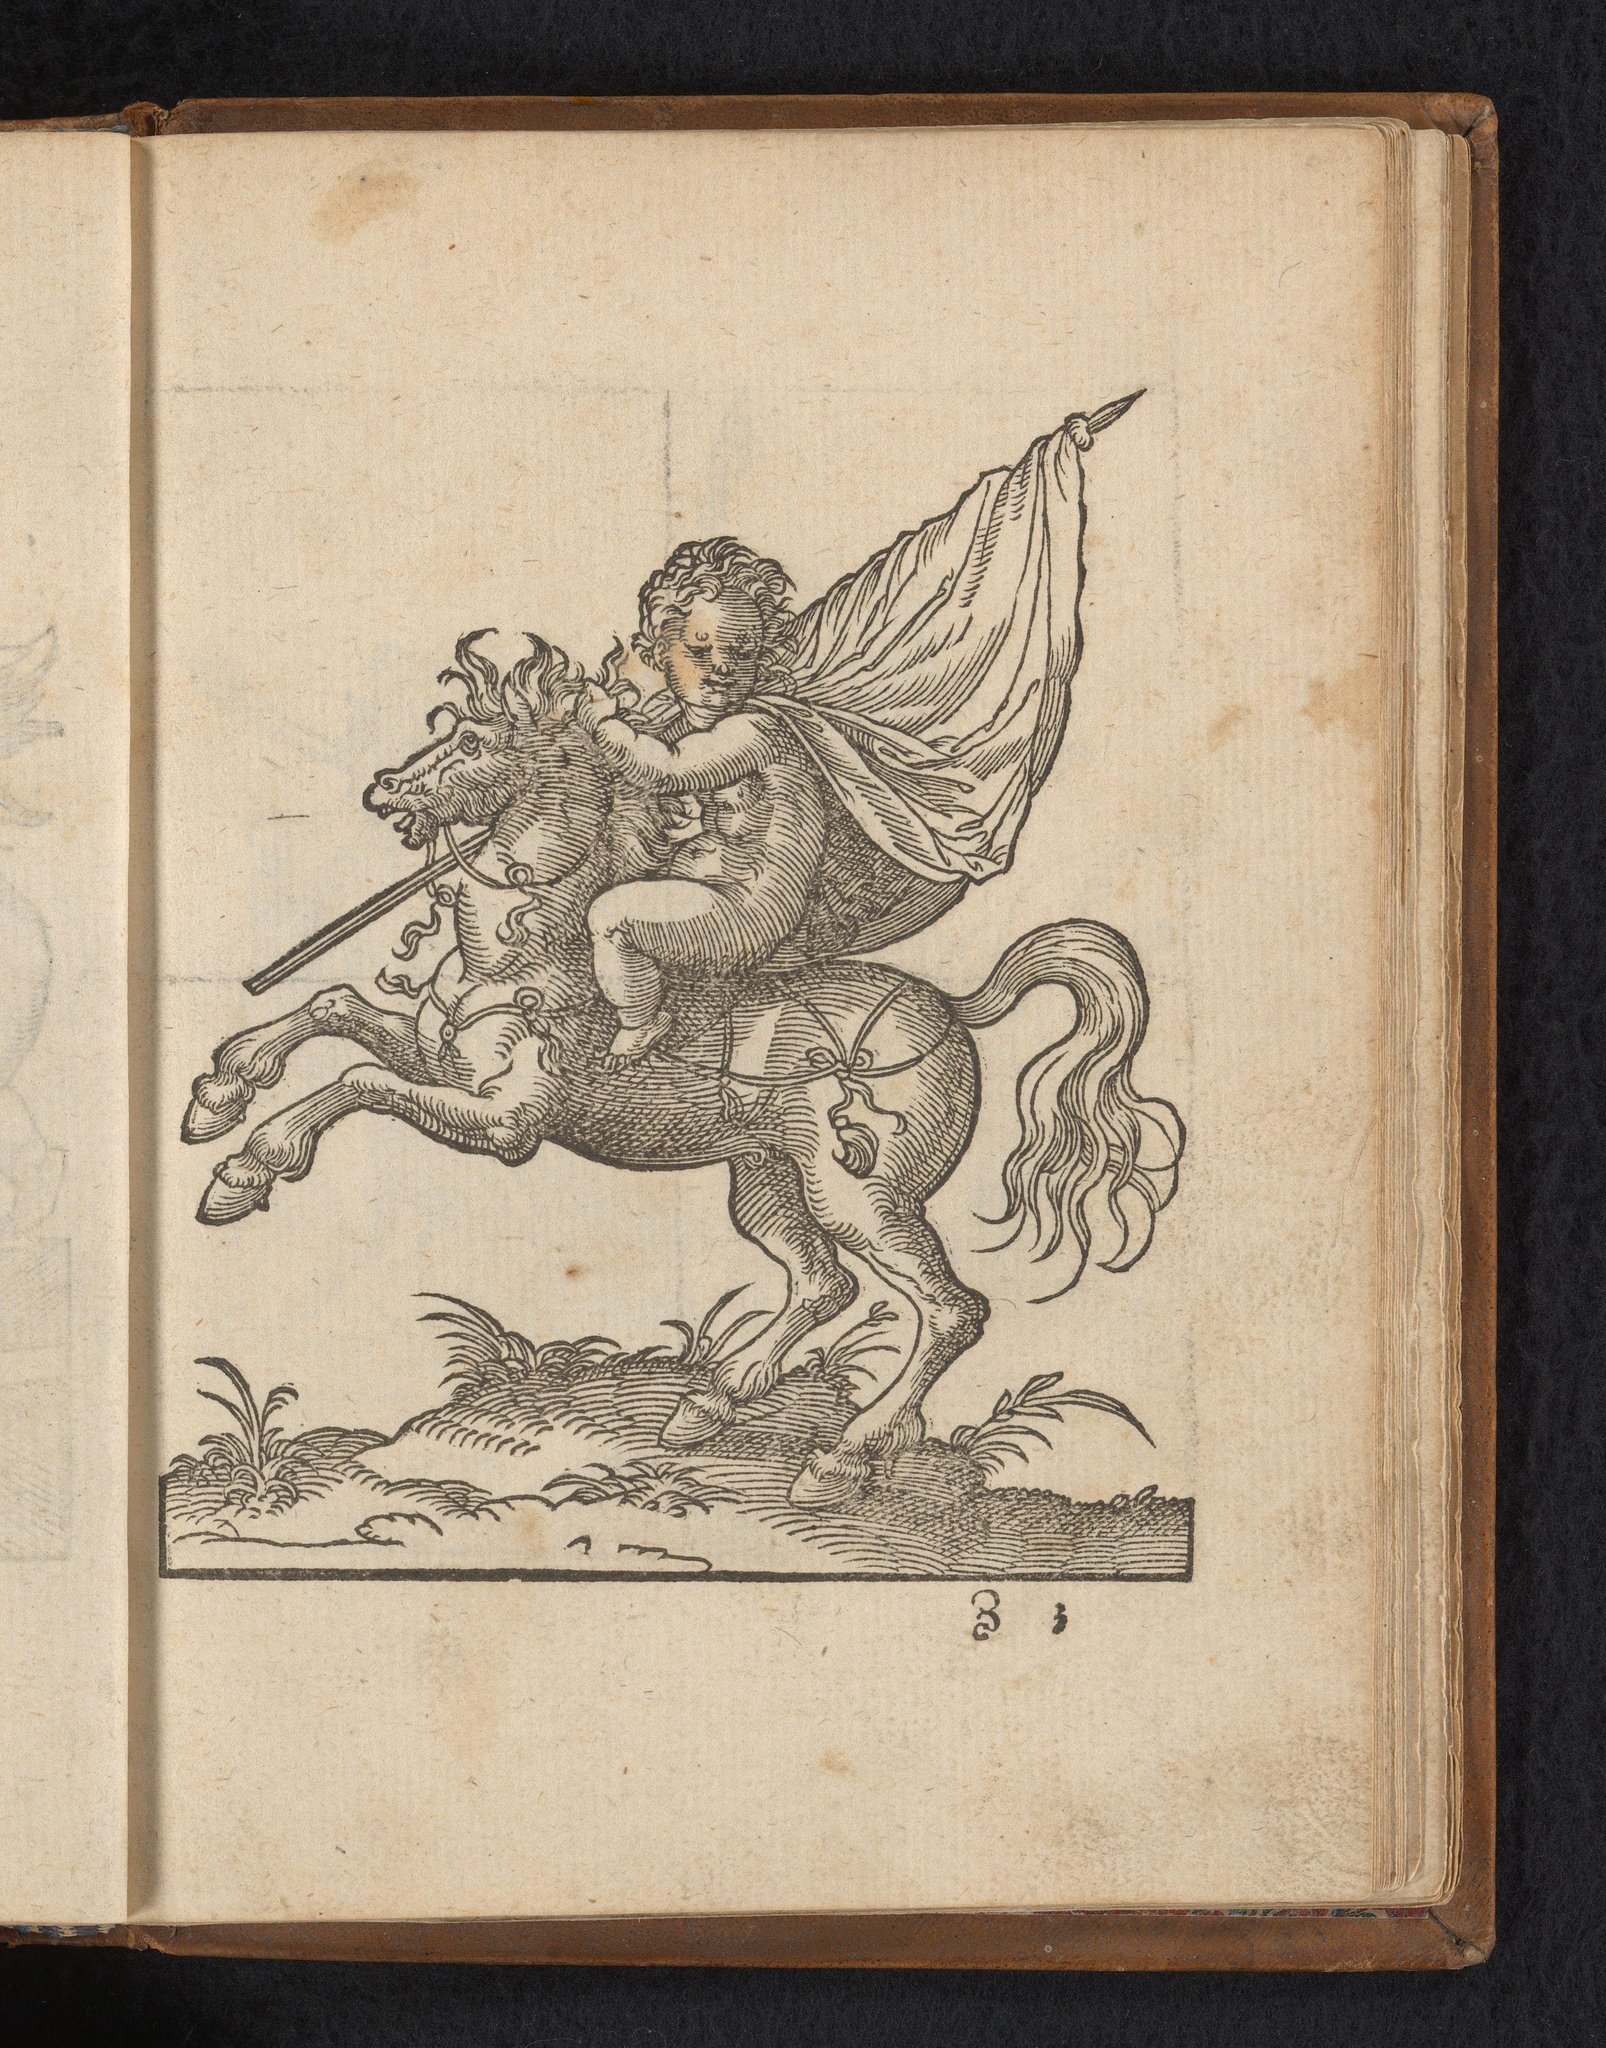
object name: print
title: Kind met vaandel te paard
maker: Anonymous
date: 1578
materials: paper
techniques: woodcut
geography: nuremberg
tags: riding a horse, ass, or mule; rider, horseman, rearing (horse in motion), standard-bearer, flag-bearer, children behaving like adults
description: Naakt kind met vaandel rijdend op een steigerend paard. Onderdeel van het modelboek Enchiridion artis pingendi, fingendi & sculpendi met 108 figuren bedoeld voor beginnende schilders, beeldhouwers en prentmakers.